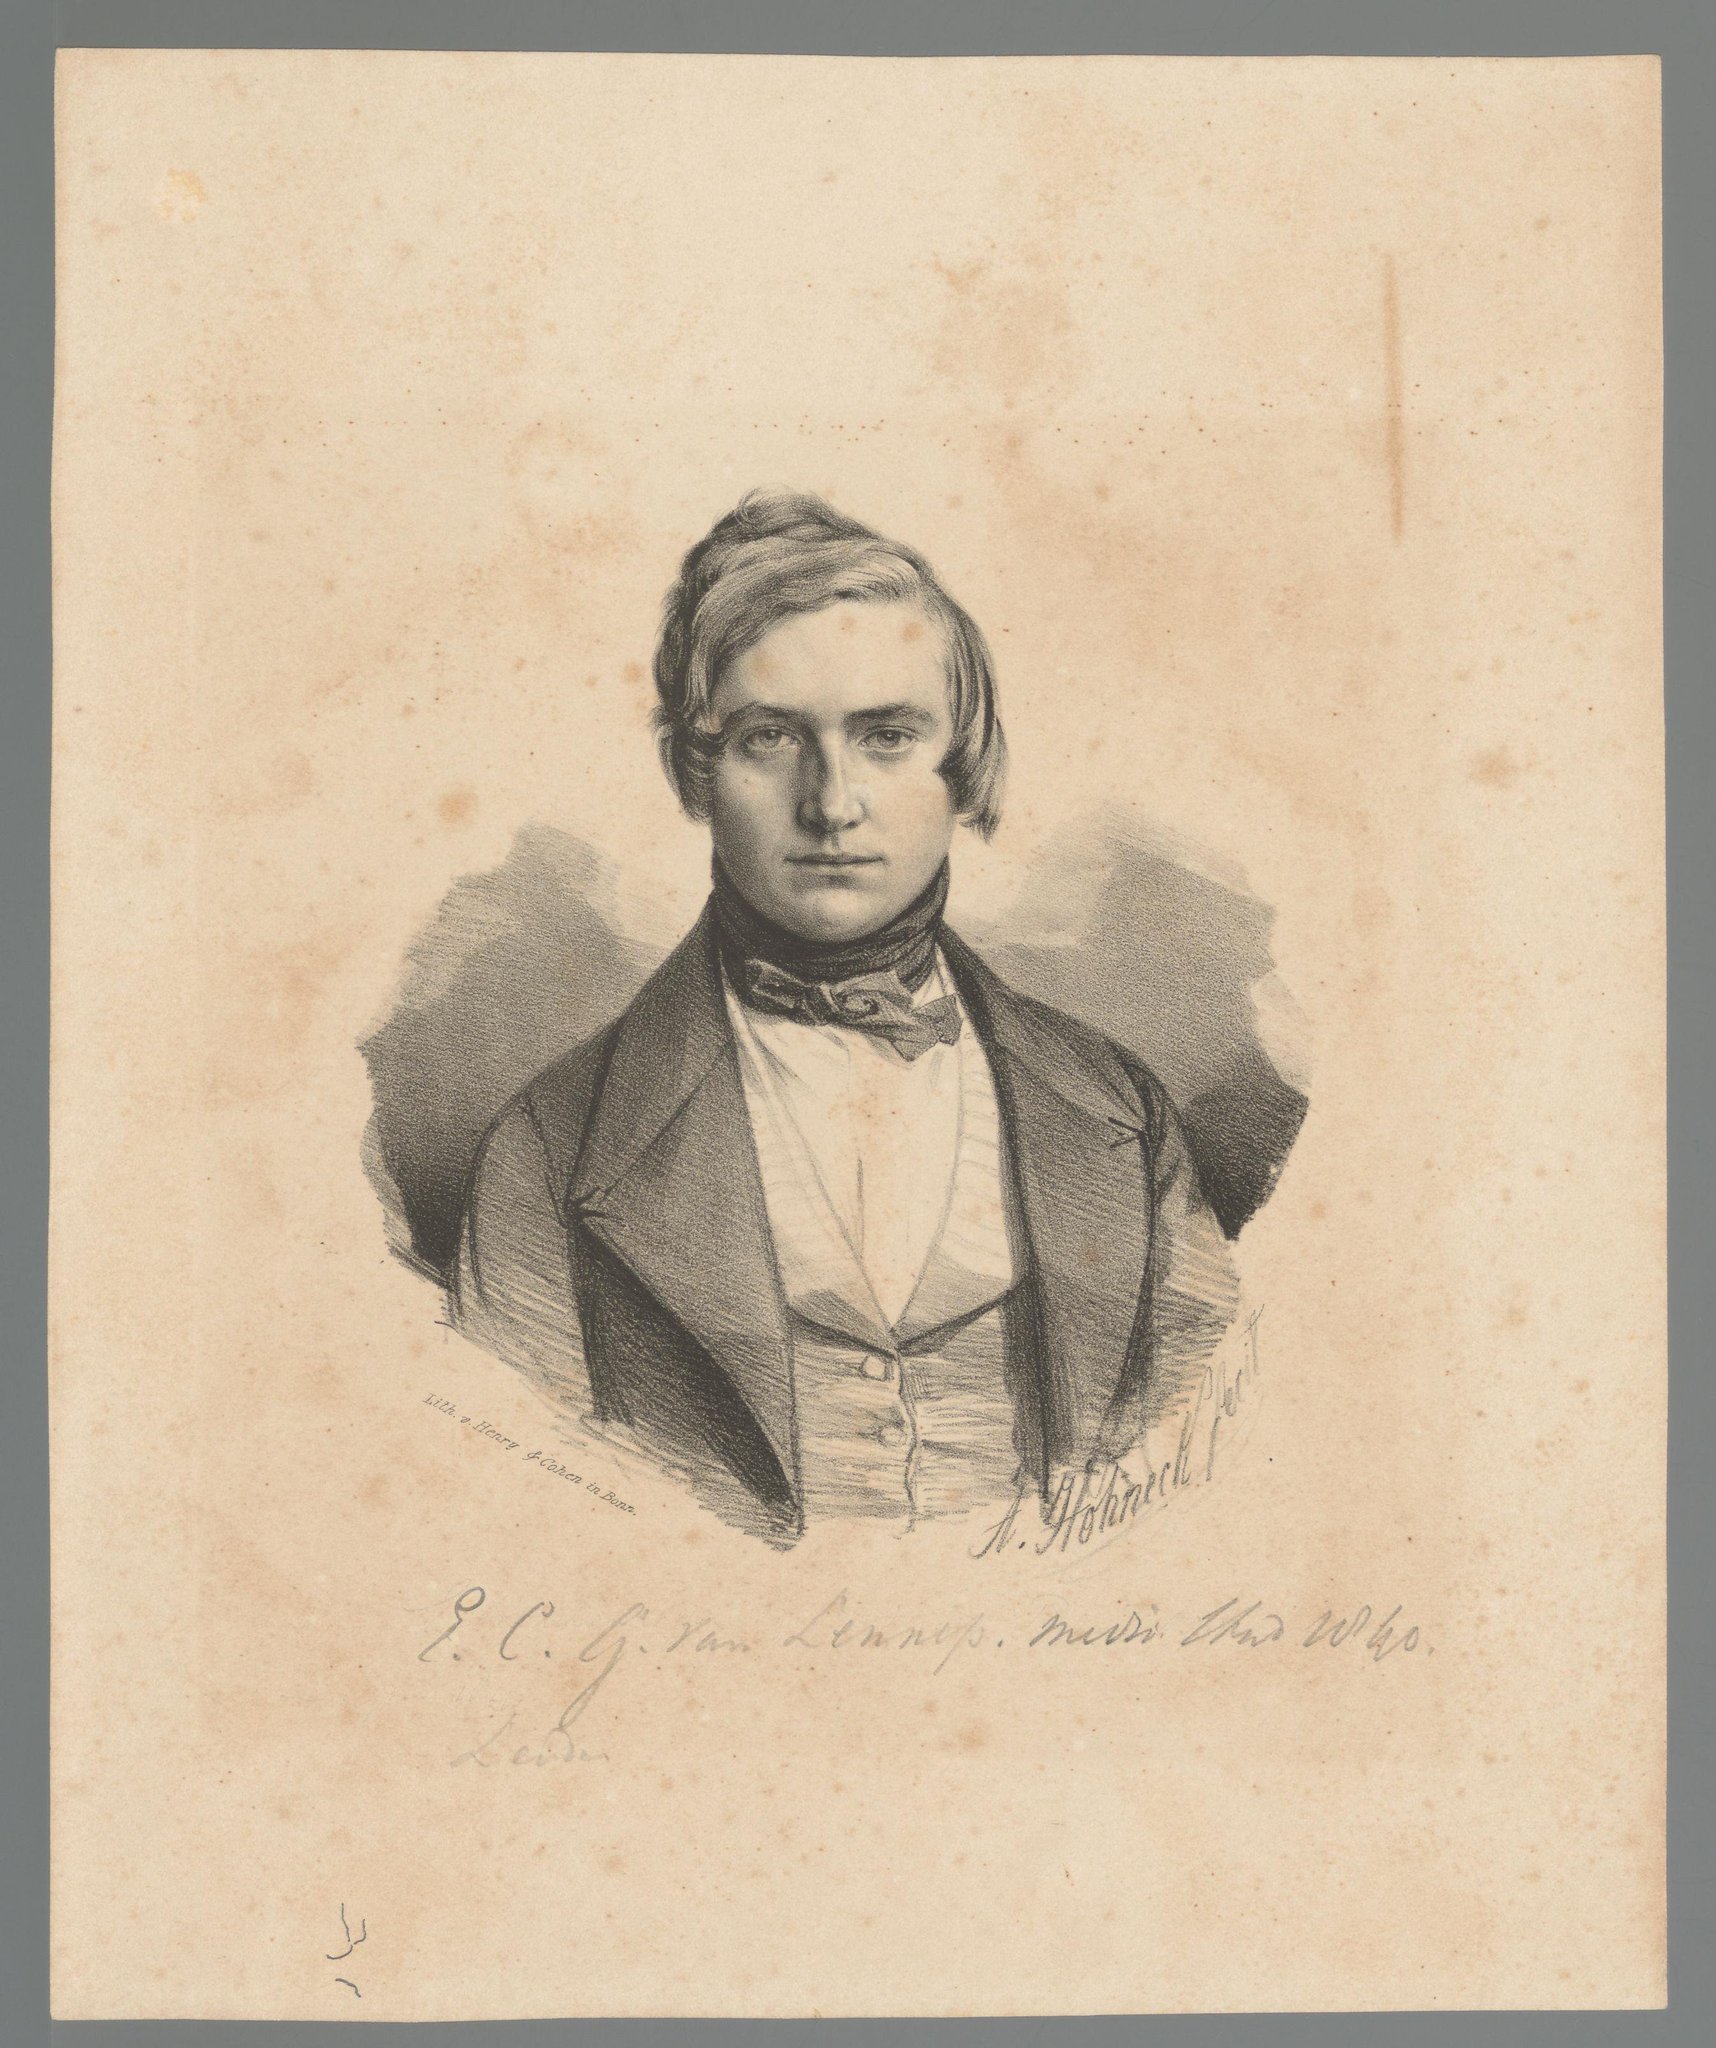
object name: print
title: Portret van een onbekende man, mogelijk E.C.G. van Lennep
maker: adolf hohneck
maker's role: print maker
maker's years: 1812-1879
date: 1822-1879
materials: paper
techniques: lithograph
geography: bonn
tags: adult man, historical persons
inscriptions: collector's mark: Lugt 2228